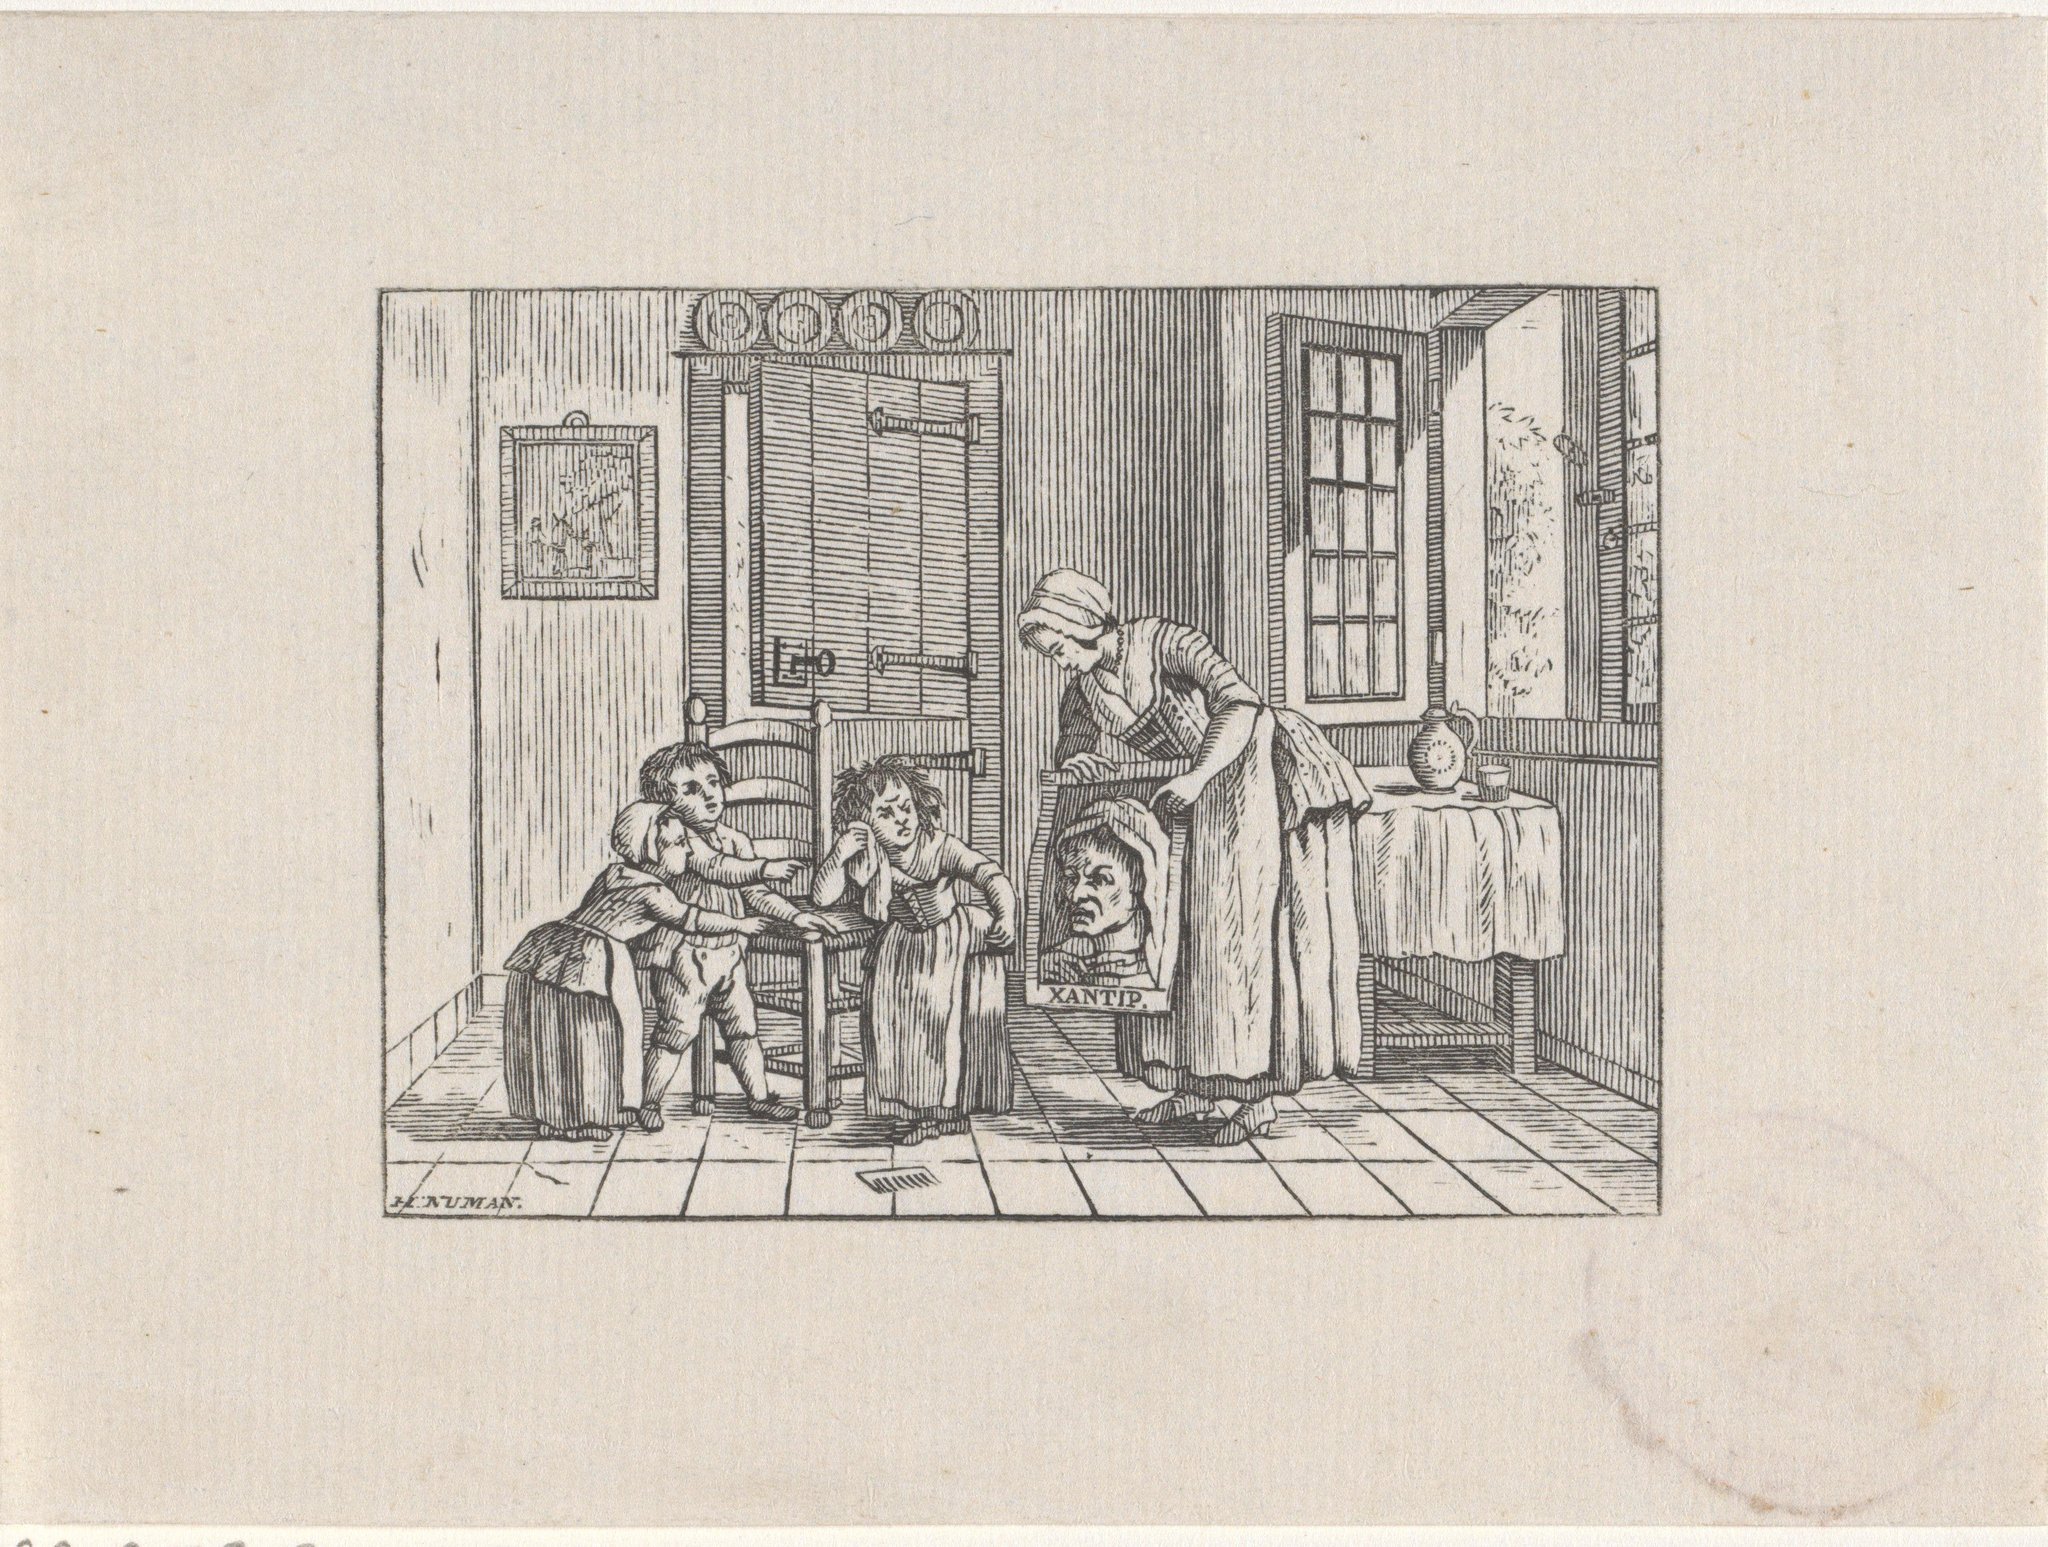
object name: print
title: Vrouw leert drie kinderen over boosaardige xantippes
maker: hendrik numan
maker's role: draughtsman, print maker, publisher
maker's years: 1736-1788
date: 1746-1788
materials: paper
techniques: woodcut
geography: haarlem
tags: boy (child between toddler and youth), girl (child between toddler and youth), education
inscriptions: collector's mark: Lugt 240